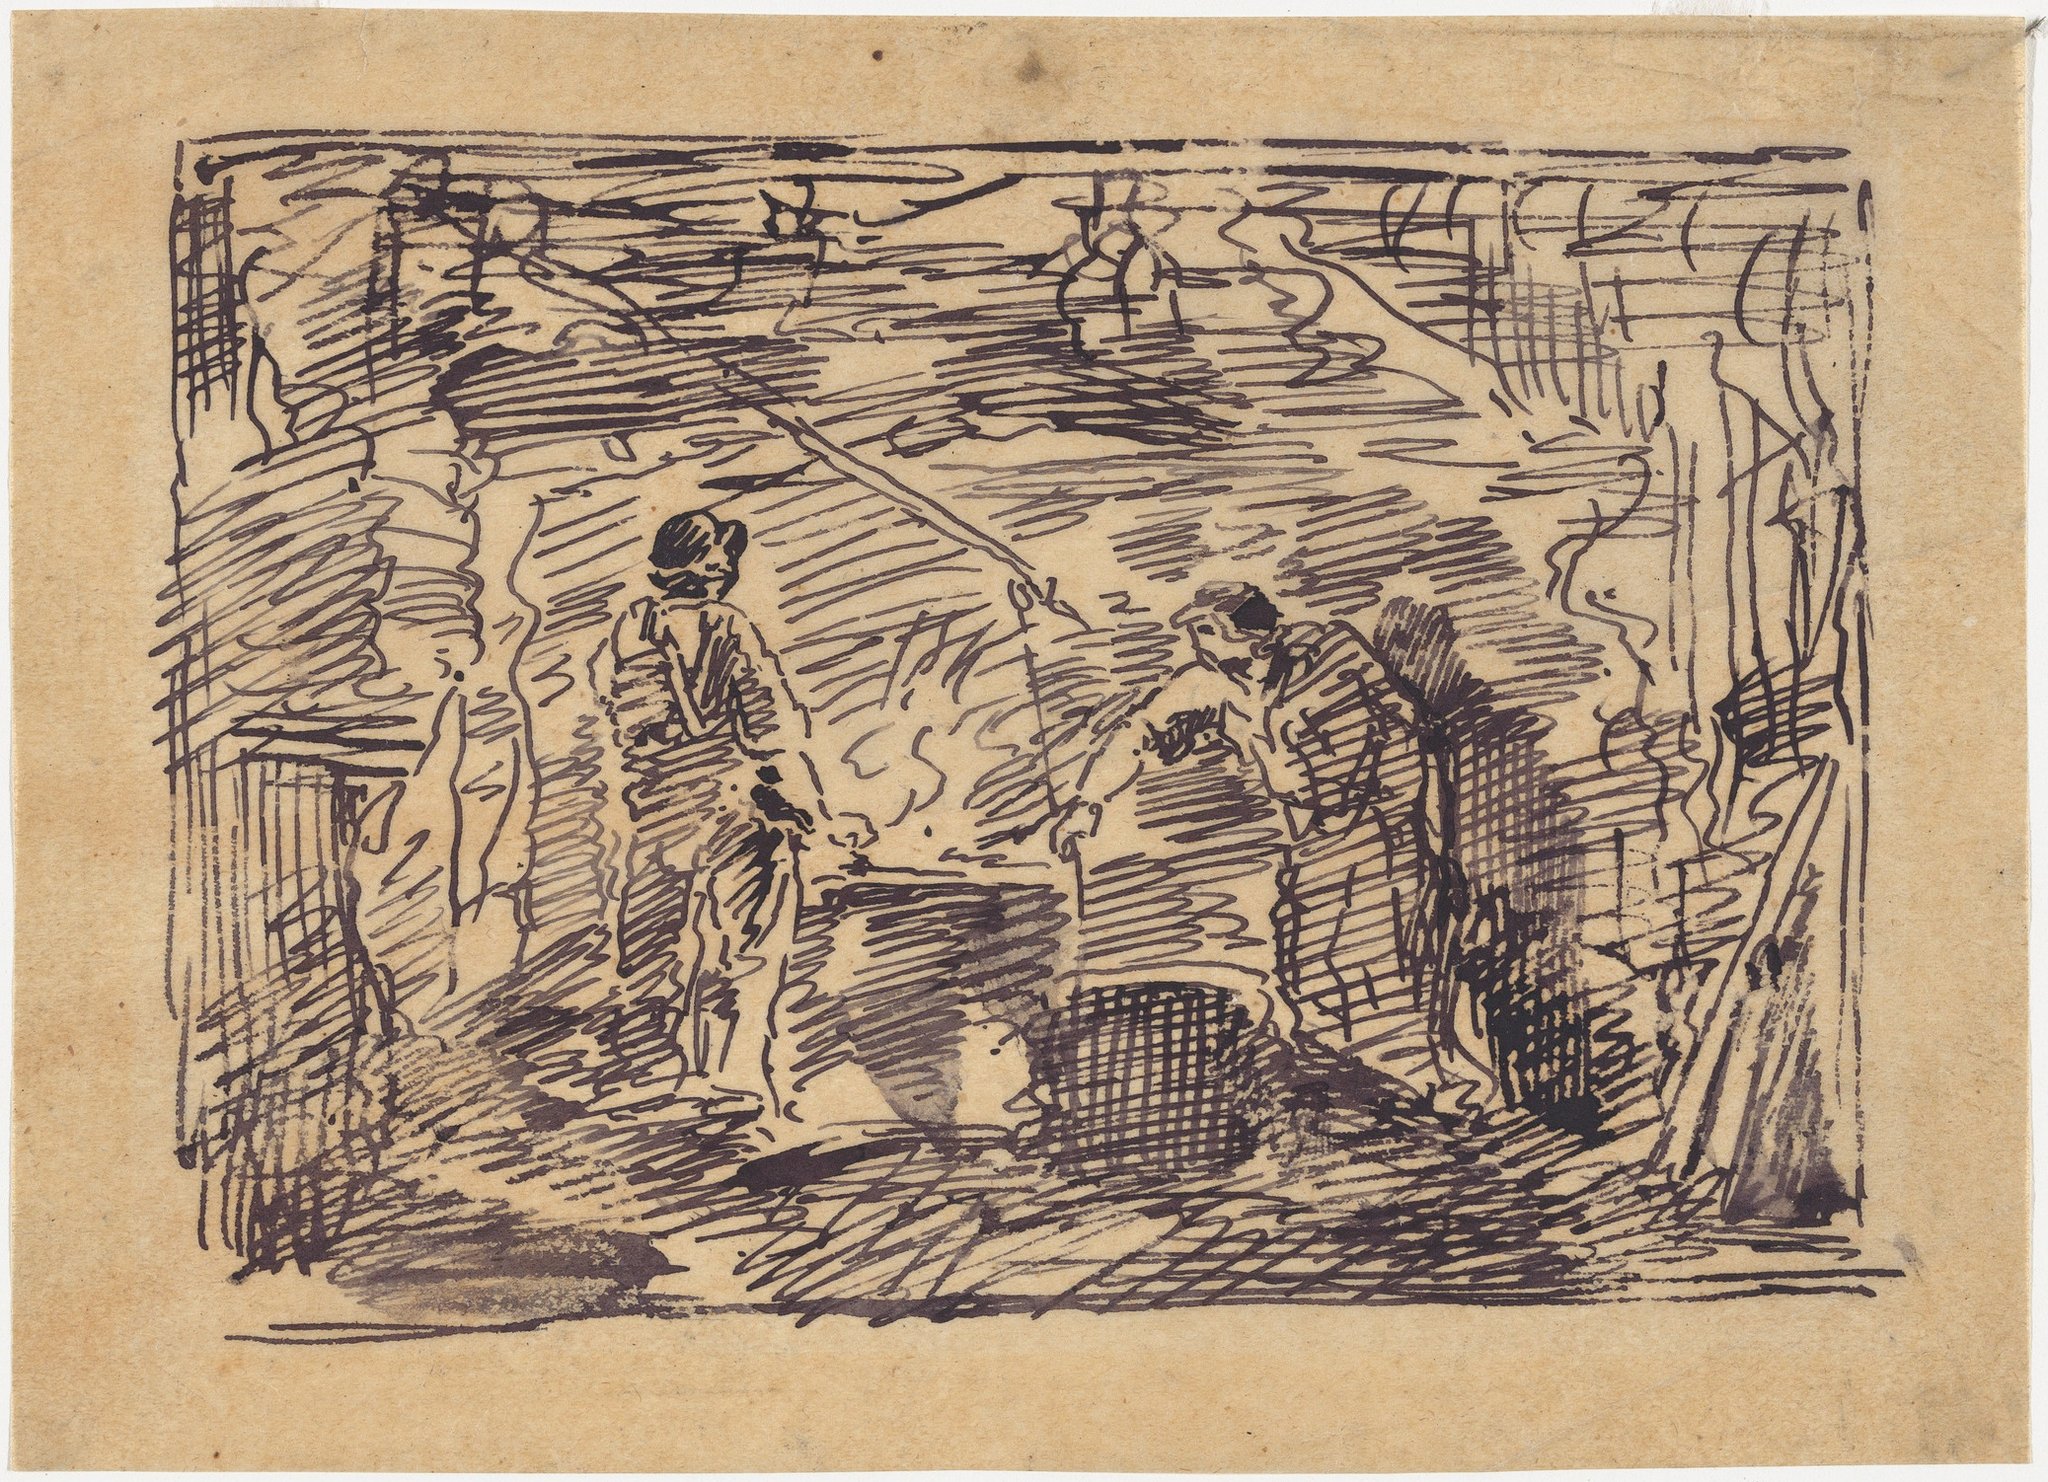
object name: drawing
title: Stirring the Pot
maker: charles-françois daubigny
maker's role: artist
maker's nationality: french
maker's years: 1817-1878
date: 1862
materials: ink, paper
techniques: pen